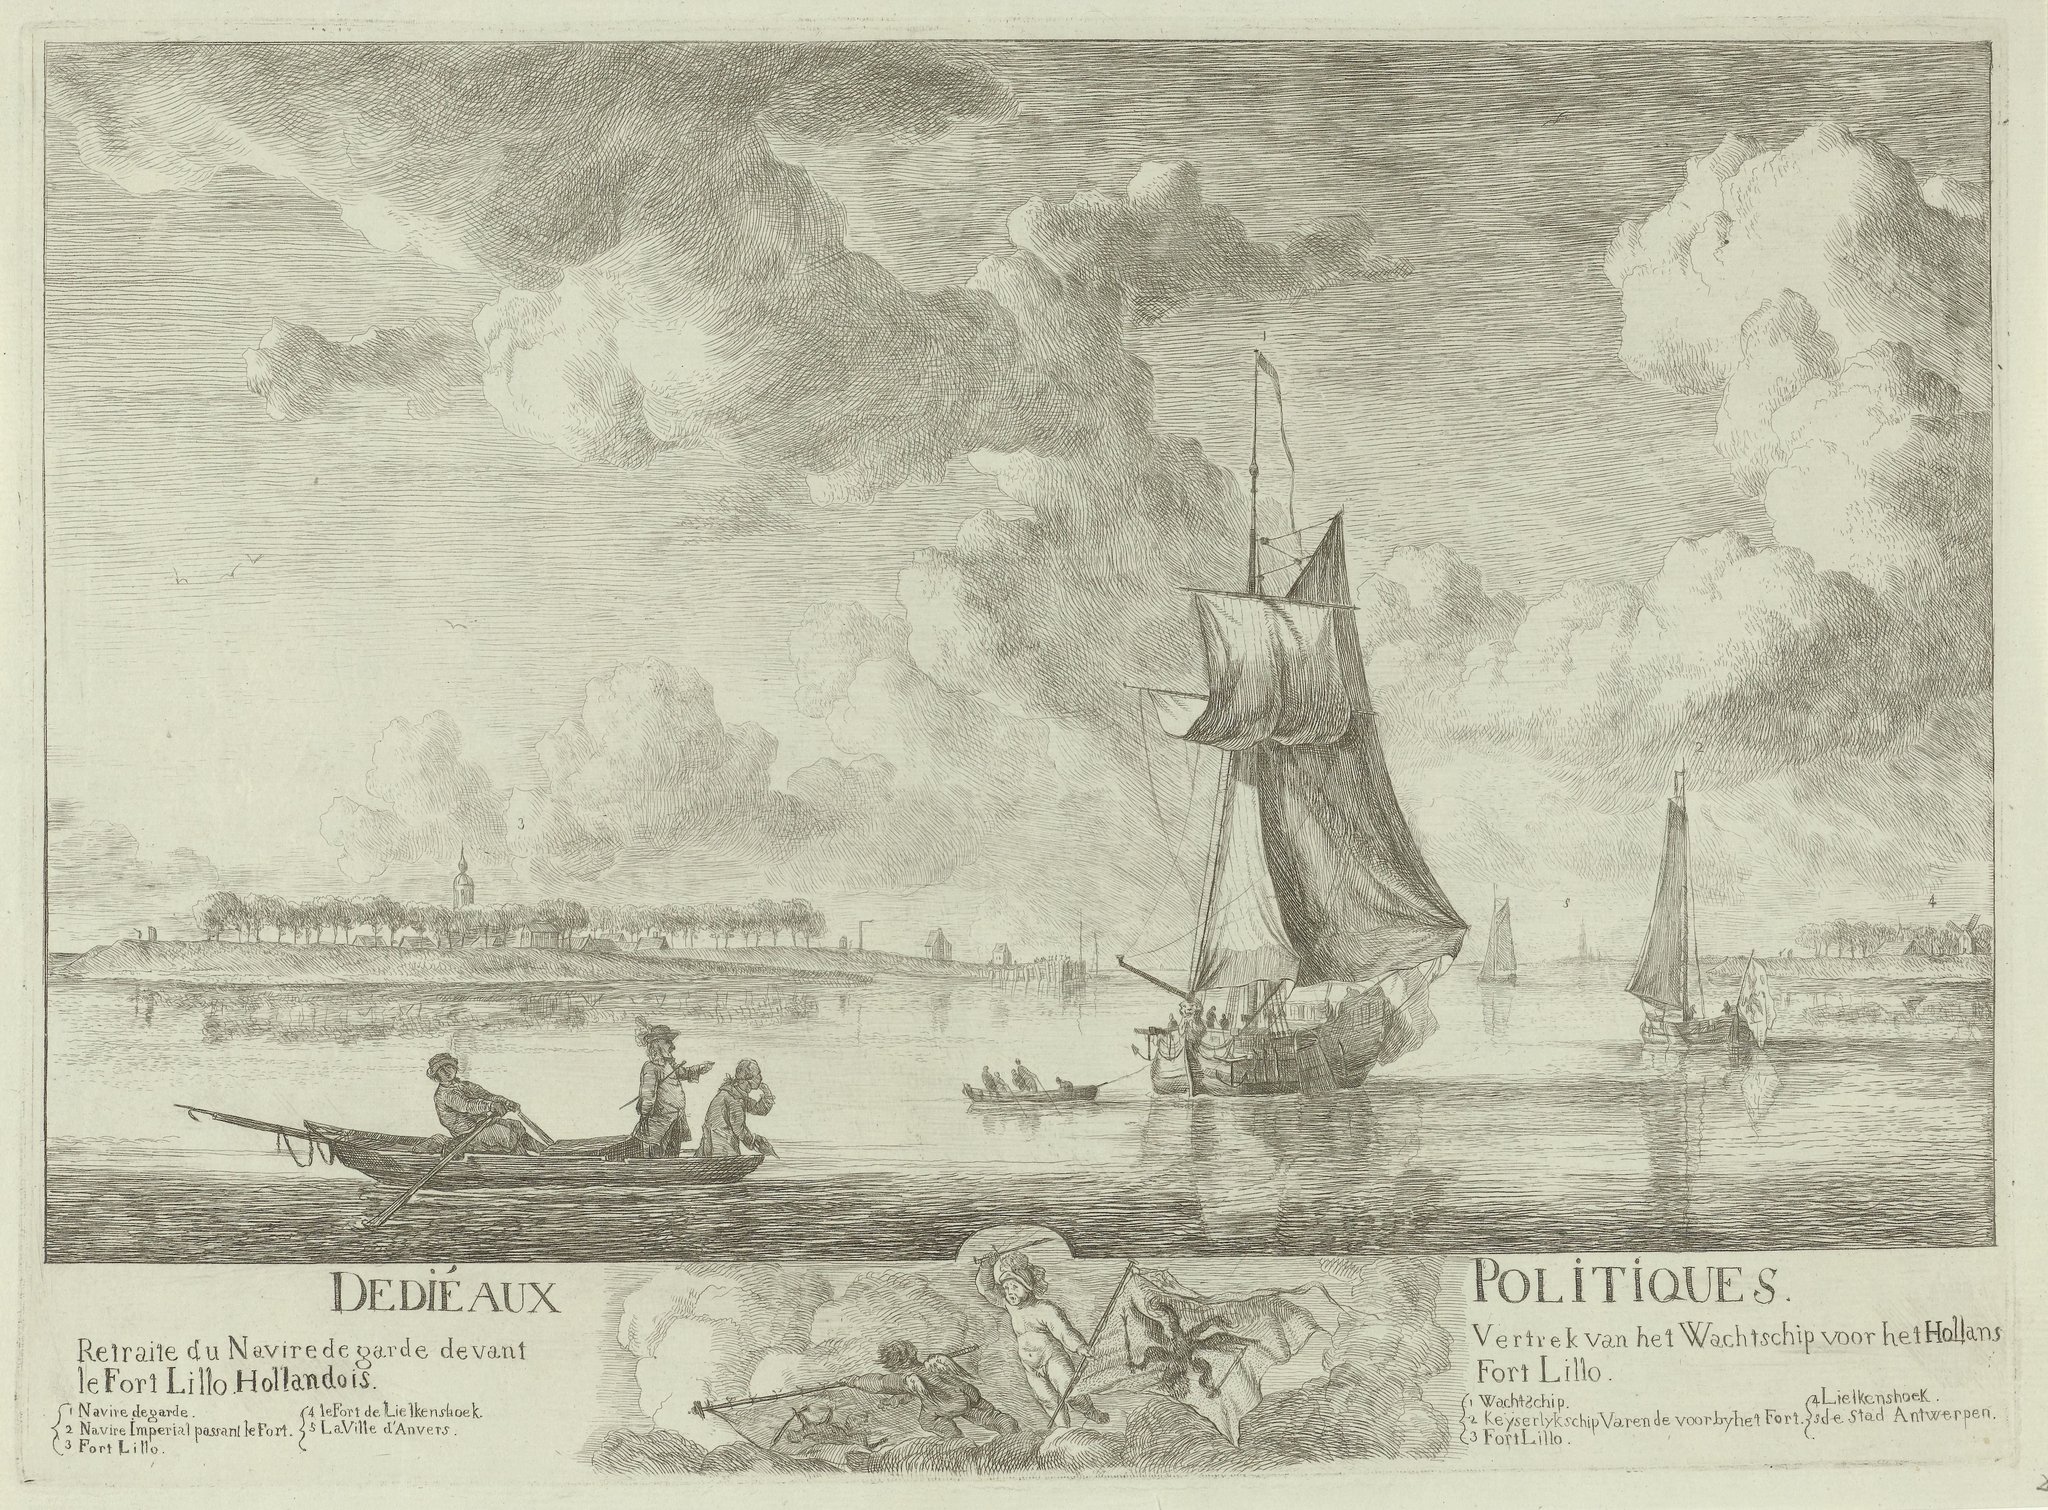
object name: print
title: Retraite du Nevire de garde devant le Fort Lillo Hollandois / Vertrek van het Wachtschip voro het Hollans Fort Lillo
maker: Anonymous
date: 1784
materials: paper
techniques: engraving, etching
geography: northern netherlands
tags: ships (in general) (+ propulsion of vehicle, ship, etc. by wind)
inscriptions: collector's mark: Lugt 2228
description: Rivierlandschap met het incident waarbij de keizerlijke brik Louis voorbij Fort Lillo en het Nederlandse wachtschip de Schelde opvaart, 8 oktober 1784. In de marge onder de voorstelling de titels, de opdracht "Dedié aux Politiques" en legenda's in het Frans en Nederlands aan weerszijden van een allegorisch vignet met twee strijdende putti met de keizerlijke en de Nederlandse vaandel. Bij de prent behoort een pendant.